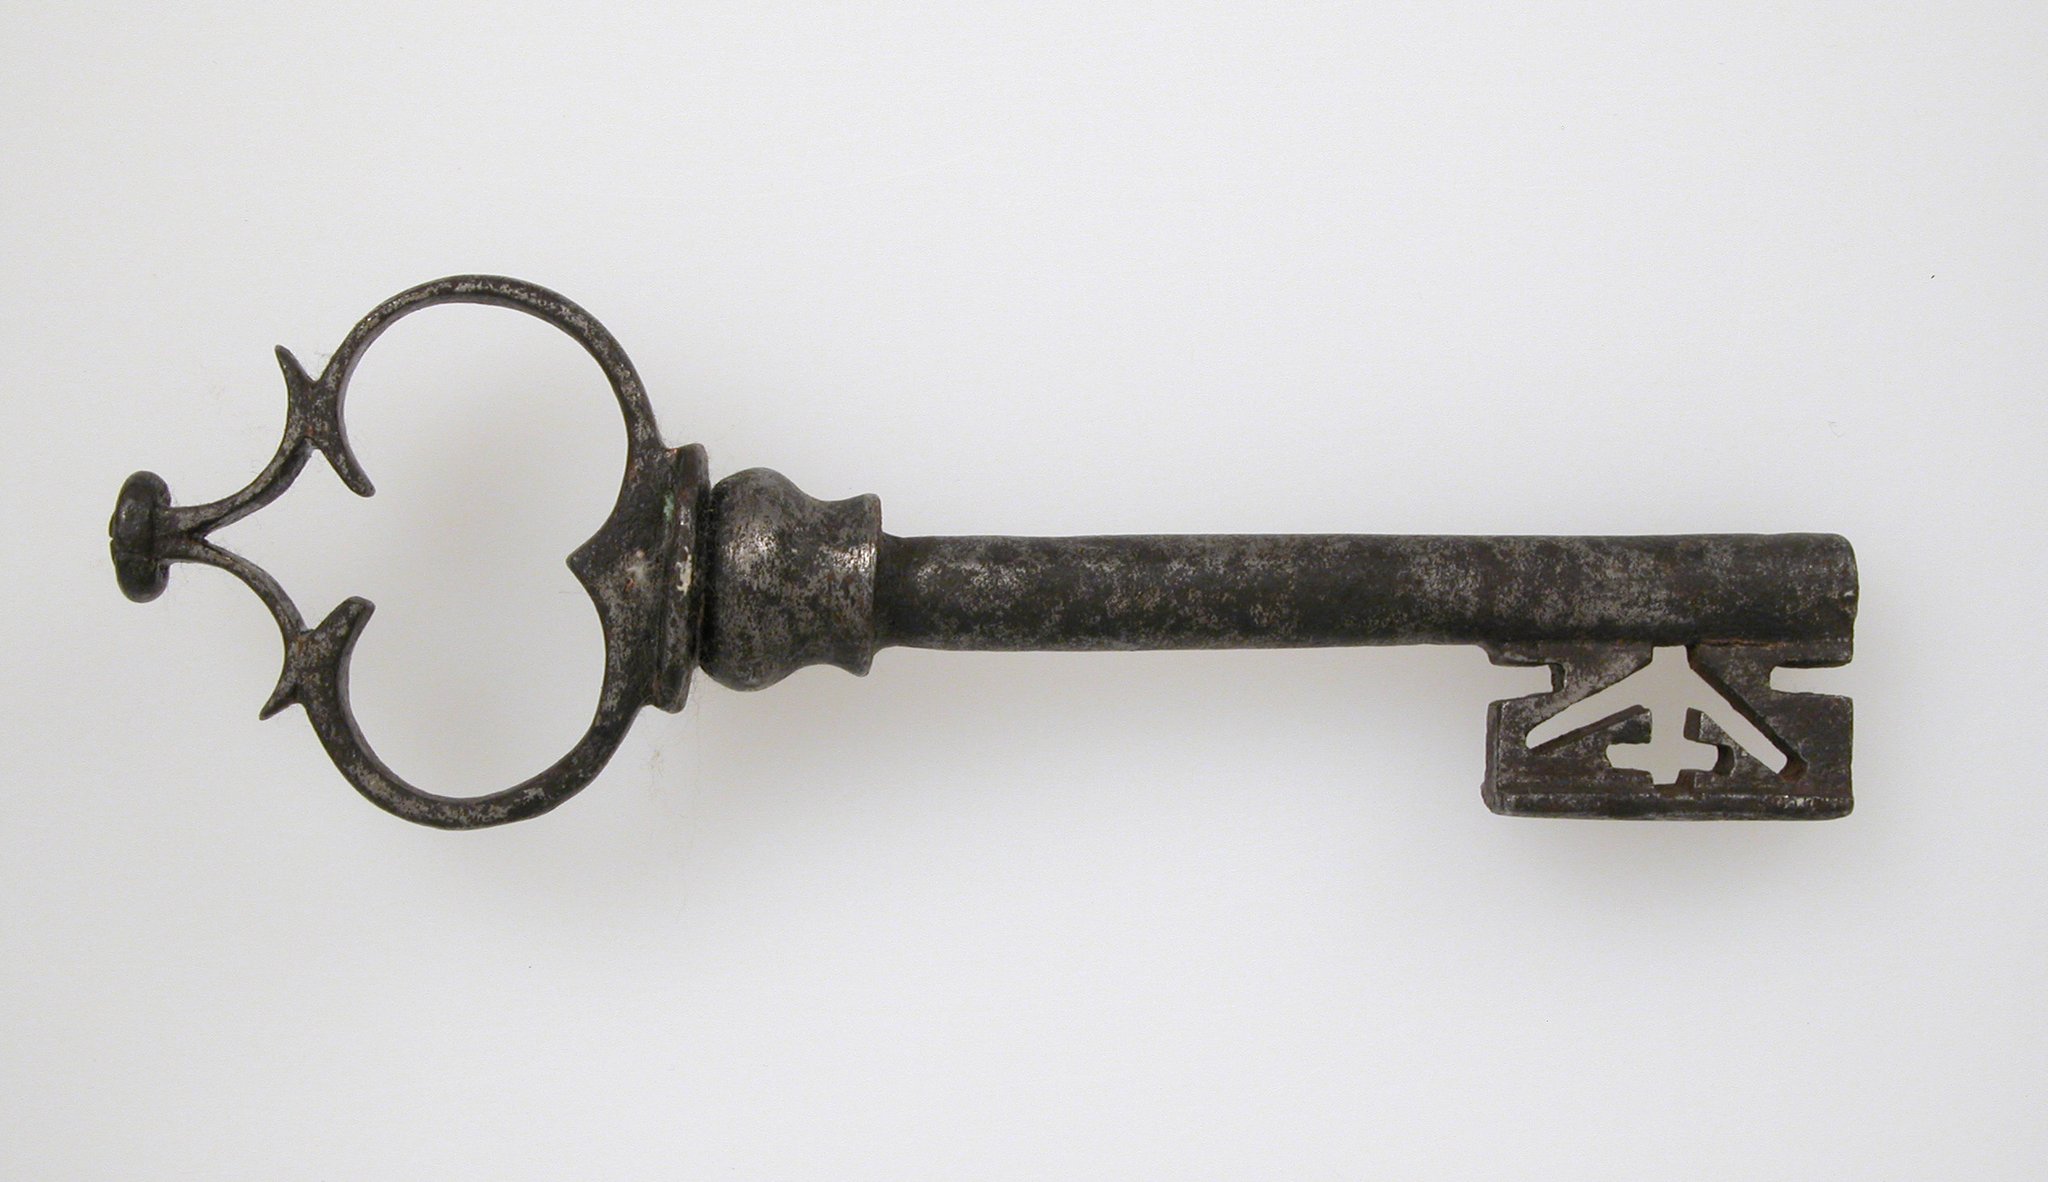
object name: key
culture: german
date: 1401-1500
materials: iron